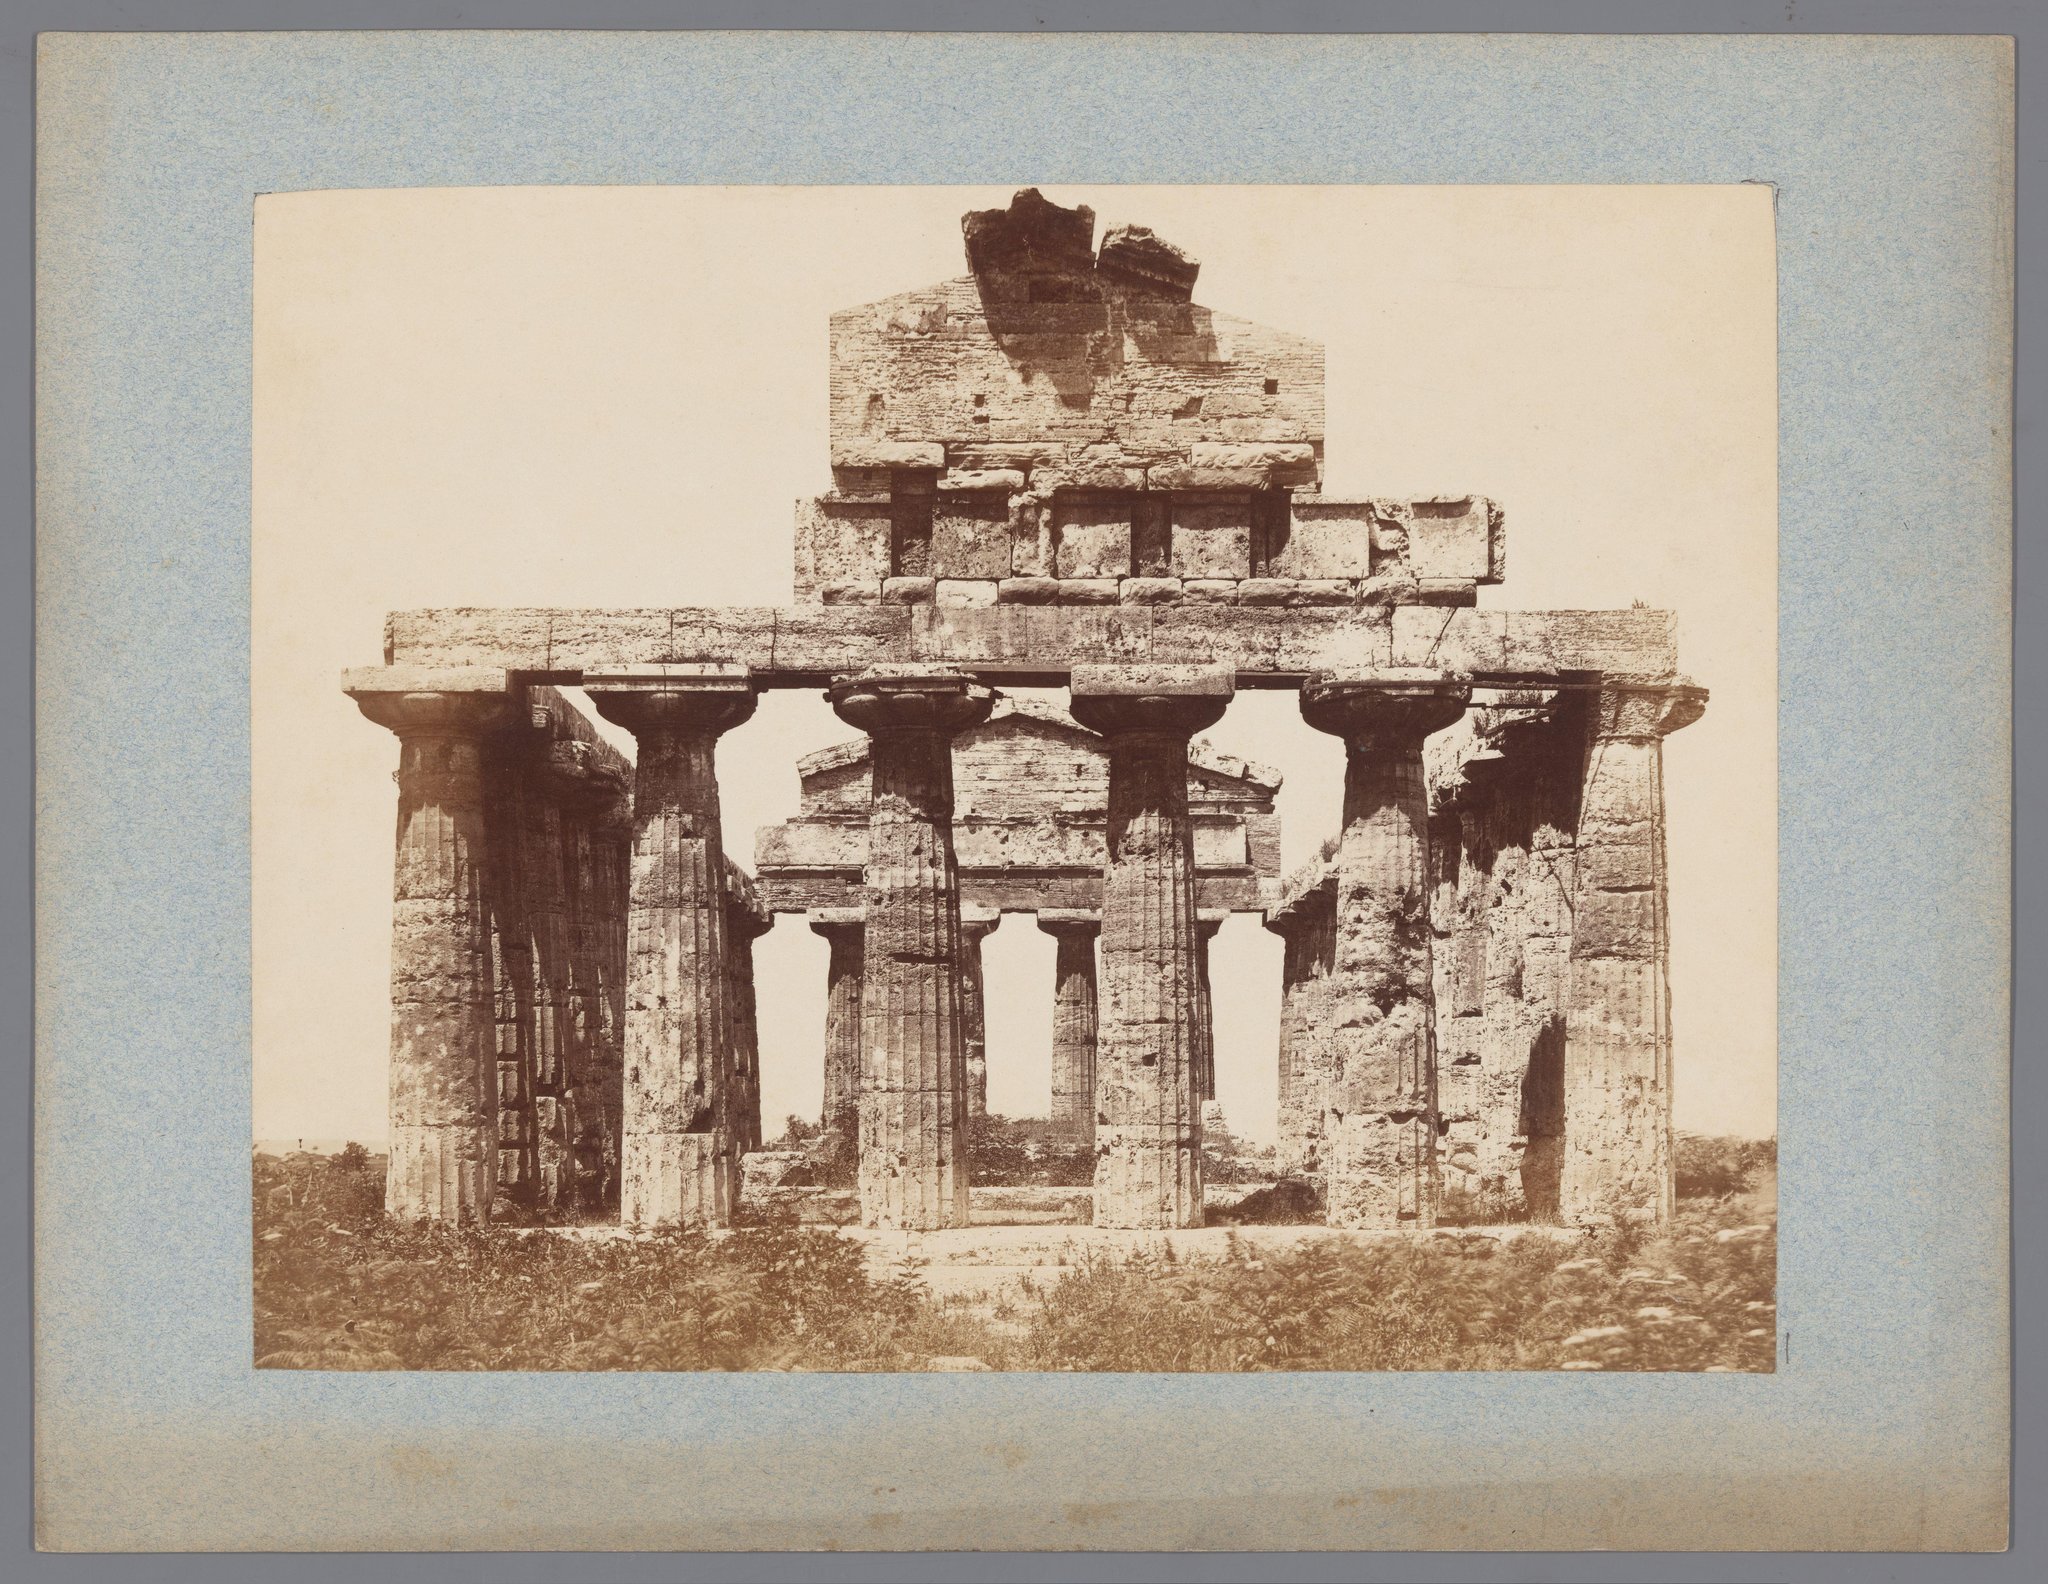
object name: photograph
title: Tempio di Cerere, Pesto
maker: Anonymous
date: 1851-1900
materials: cardboard, paper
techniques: albumen print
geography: paestum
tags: ruin of a building ~ architecture, places and objects of worship ~ non-christian religions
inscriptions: number: ‘6146’, collector's mark: ‘VOSMAER’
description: Men heeft lange tijd ten onrechte aangenomen dat dit de Tempel van Ceres is geweest.